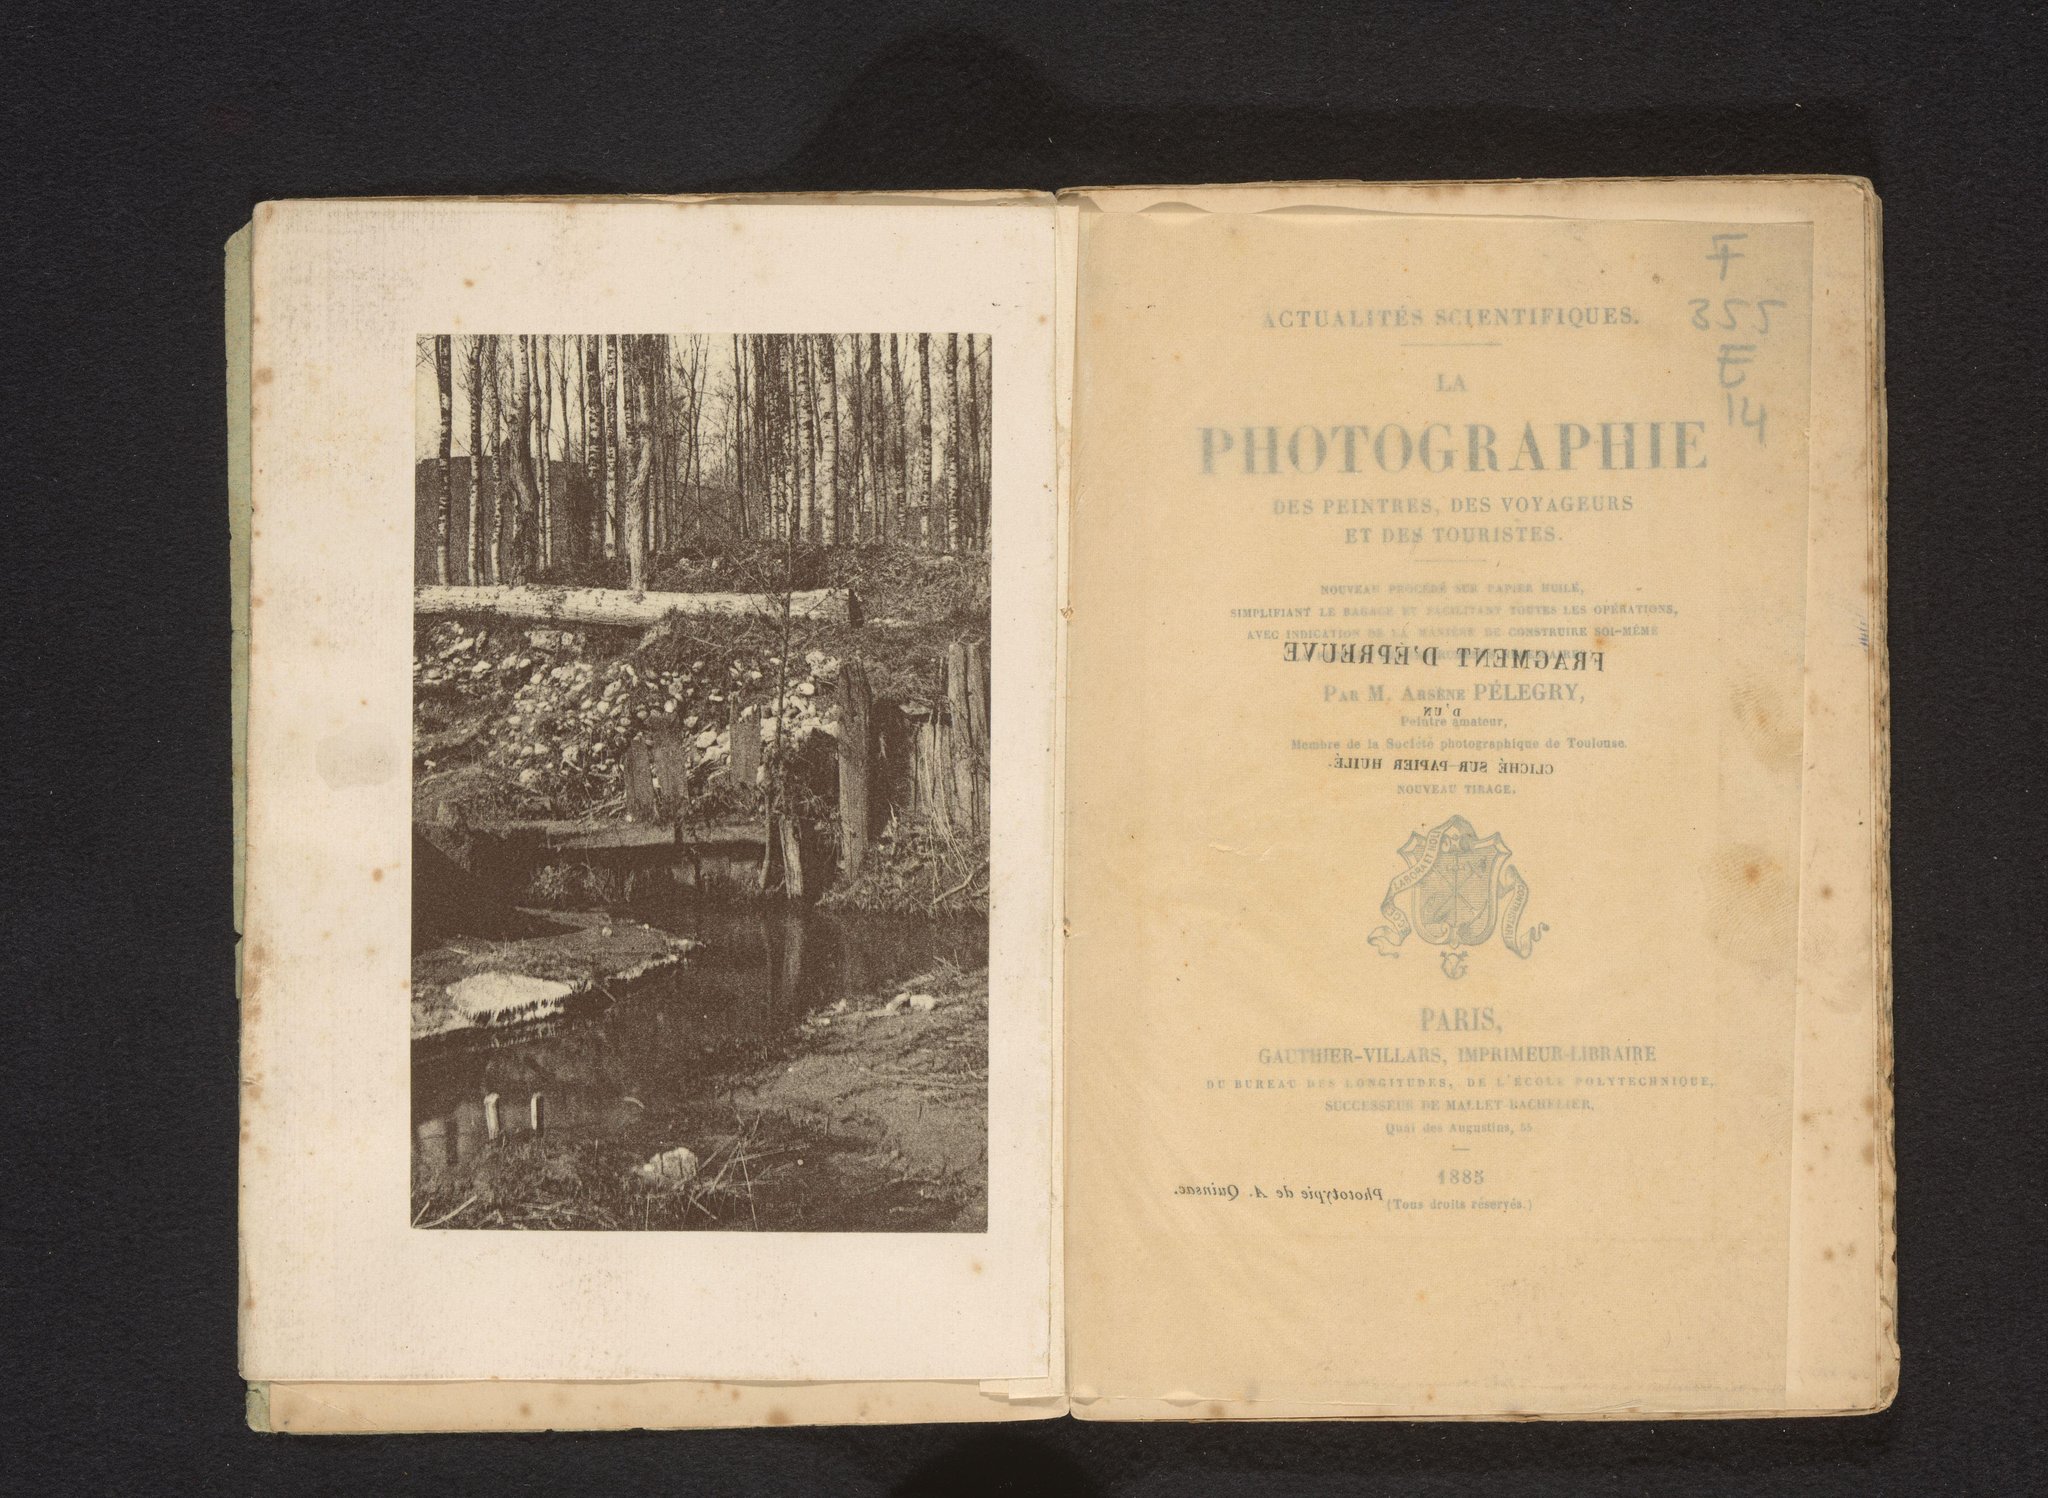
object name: photomechanical print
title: Gezicht op een bos met water en een omgevallen boom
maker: andré quinsac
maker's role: printer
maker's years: 1845-1891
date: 1875-1885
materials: paper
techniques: photograph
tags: forest, wood